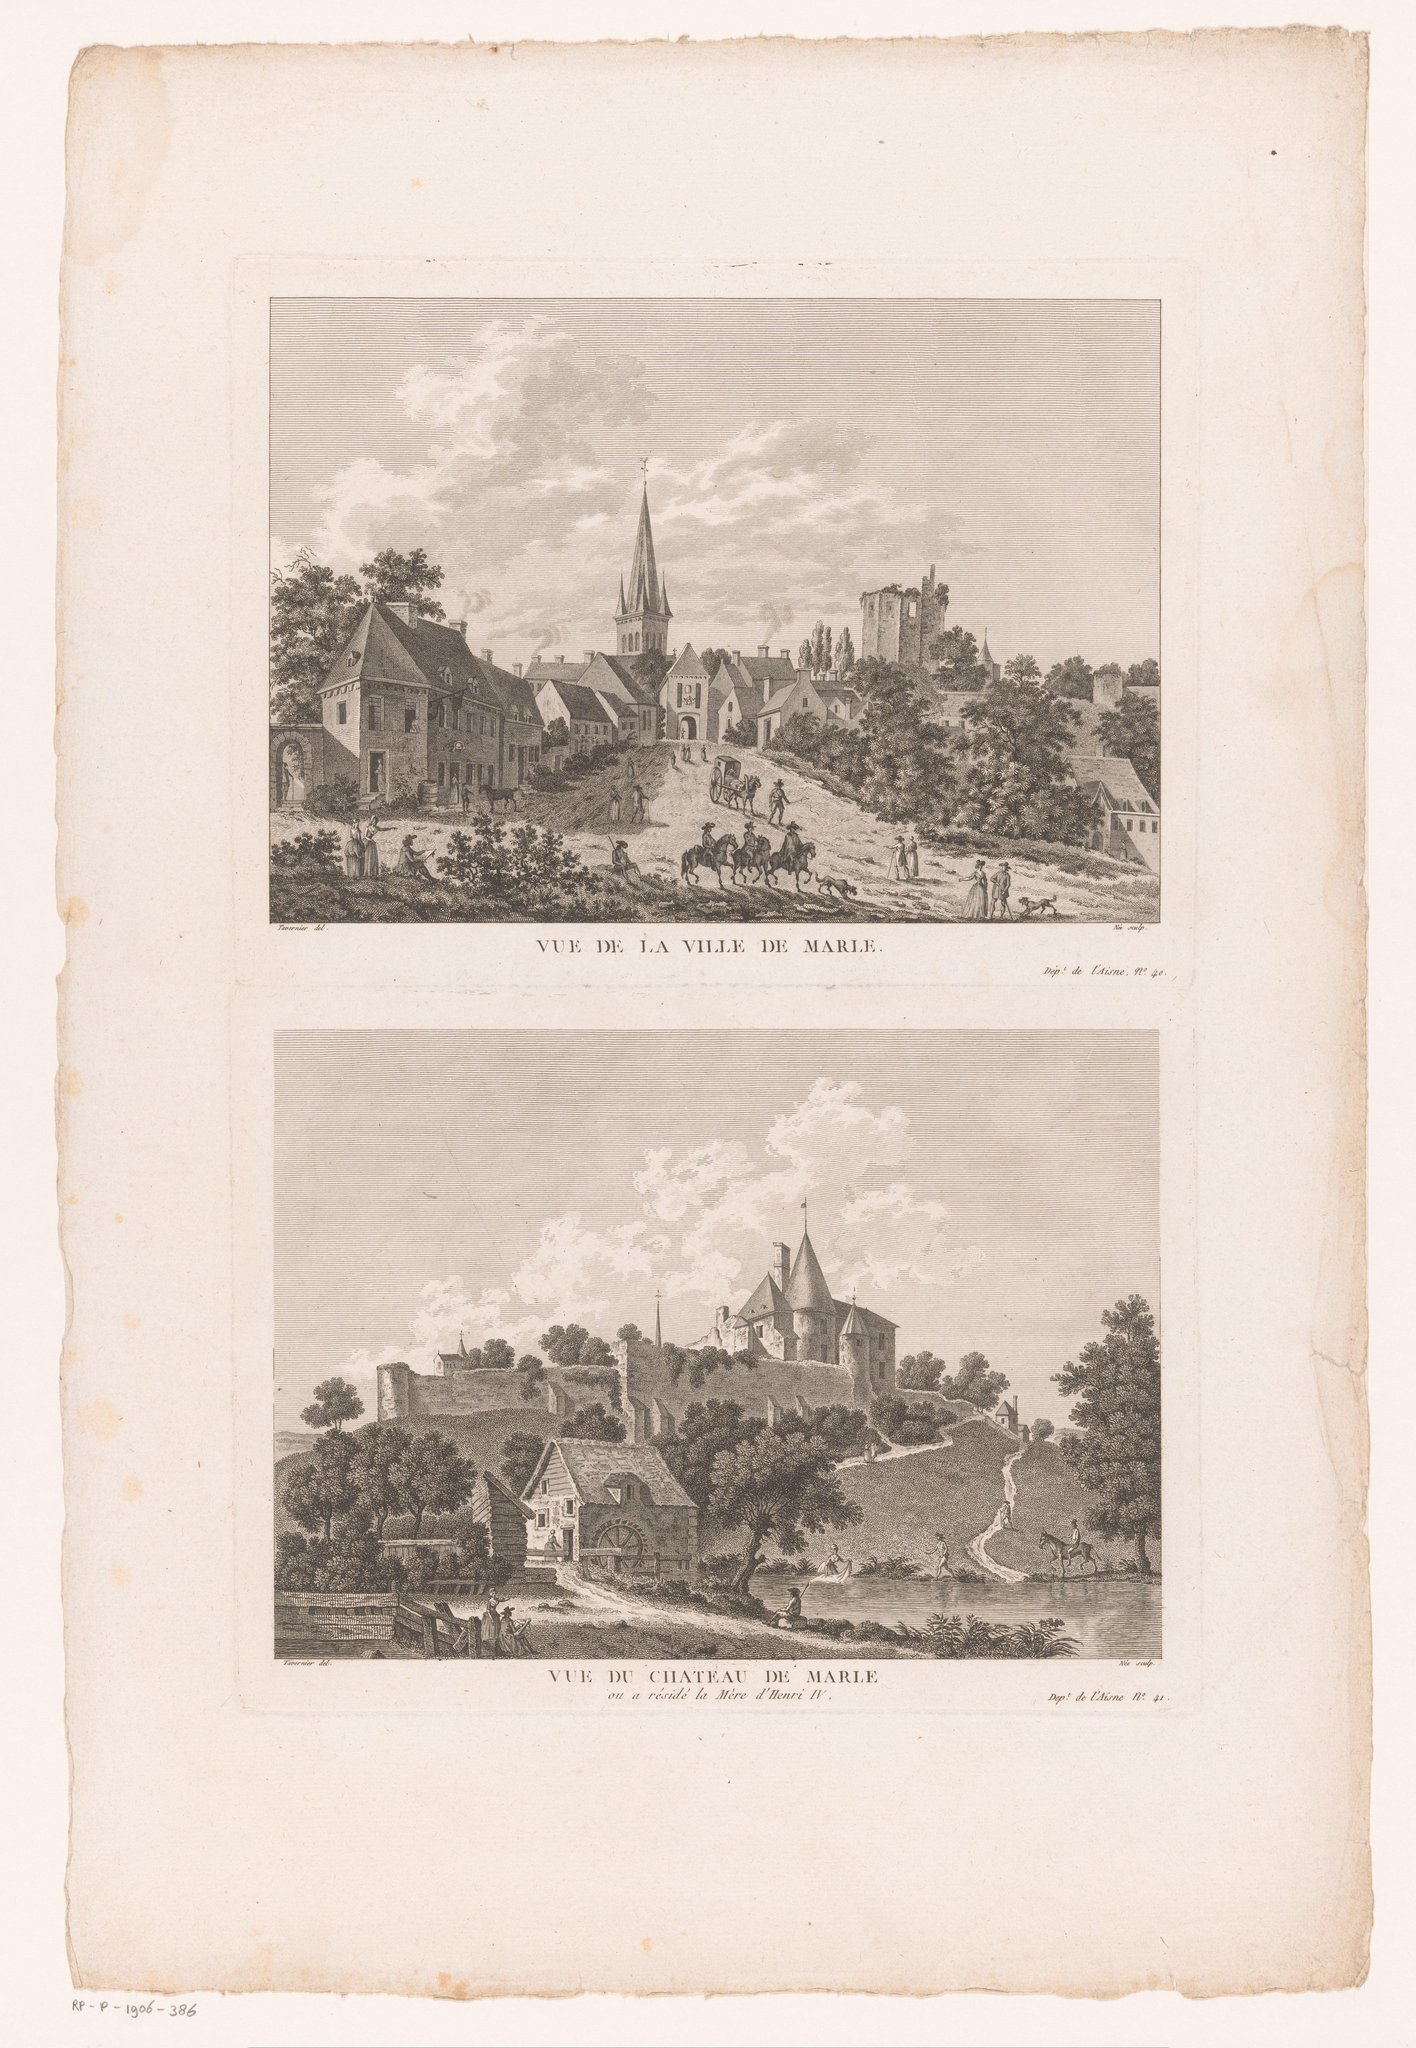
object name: print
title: Vue du Chateau de Marle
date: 1749-1817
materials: paper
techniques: etching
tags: village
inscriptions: collector's mark: Lugt 2228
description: Twee etsen op een niet versneden blad. Genummerd midden rechts: Dep.t de l'Aisne. No. 40; rechtsonder: Dep.t de l'Aisne No. 41.